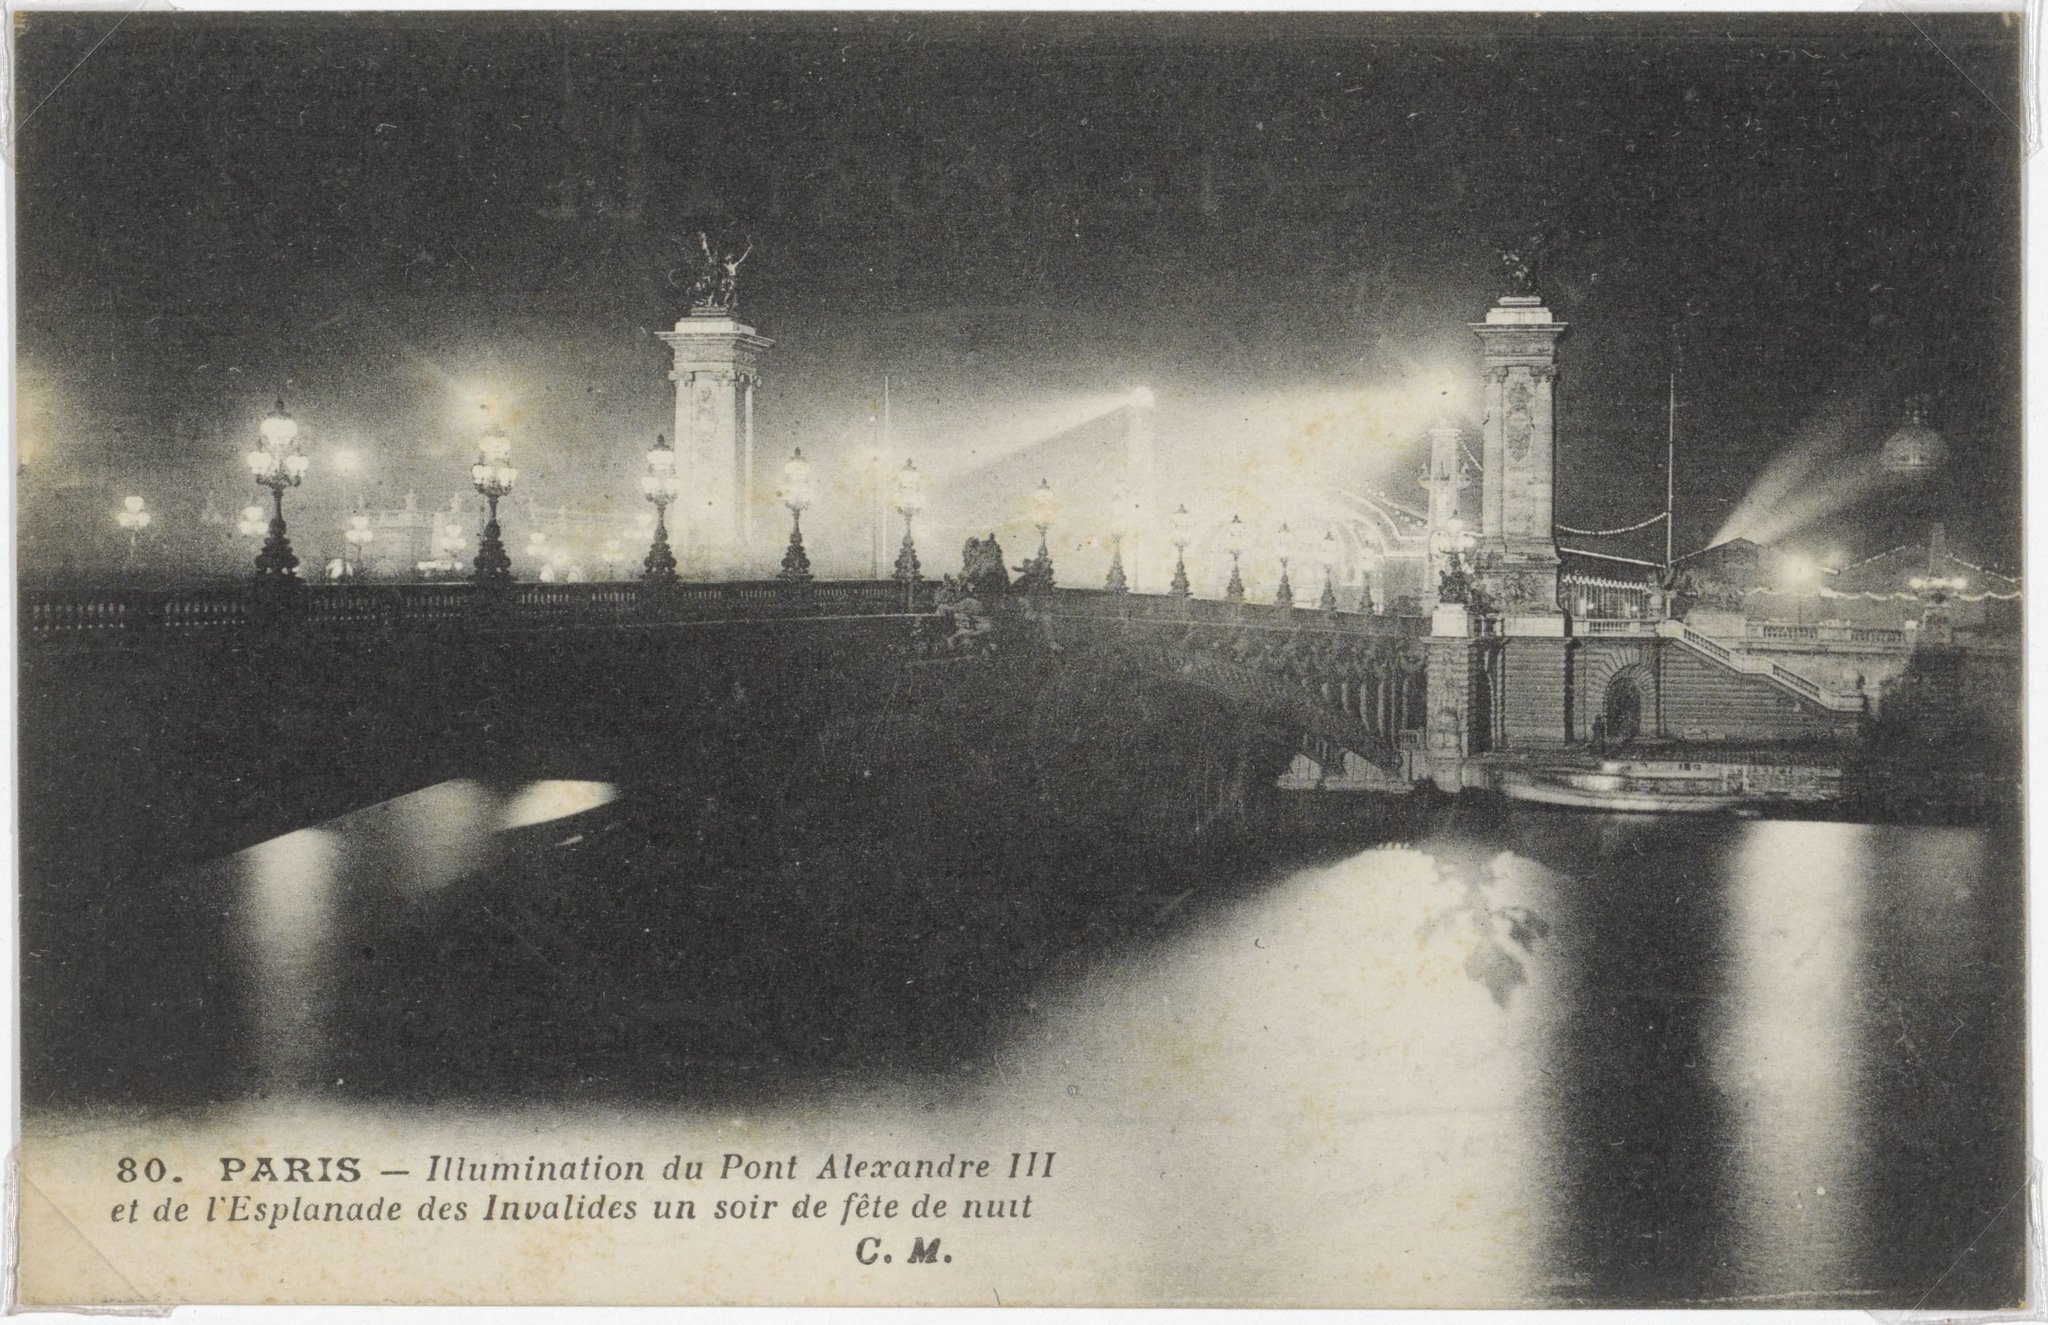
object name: photograph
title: Verlichte Pont Alexandre-III en de Esplanade des Invalides in Parijs bij nacht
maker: Anonymous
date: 1900-1925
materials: paper, photographic support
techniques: photoaquatint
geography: paris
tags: bridge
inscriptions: number: ‘80’, name: ‘C.M.’